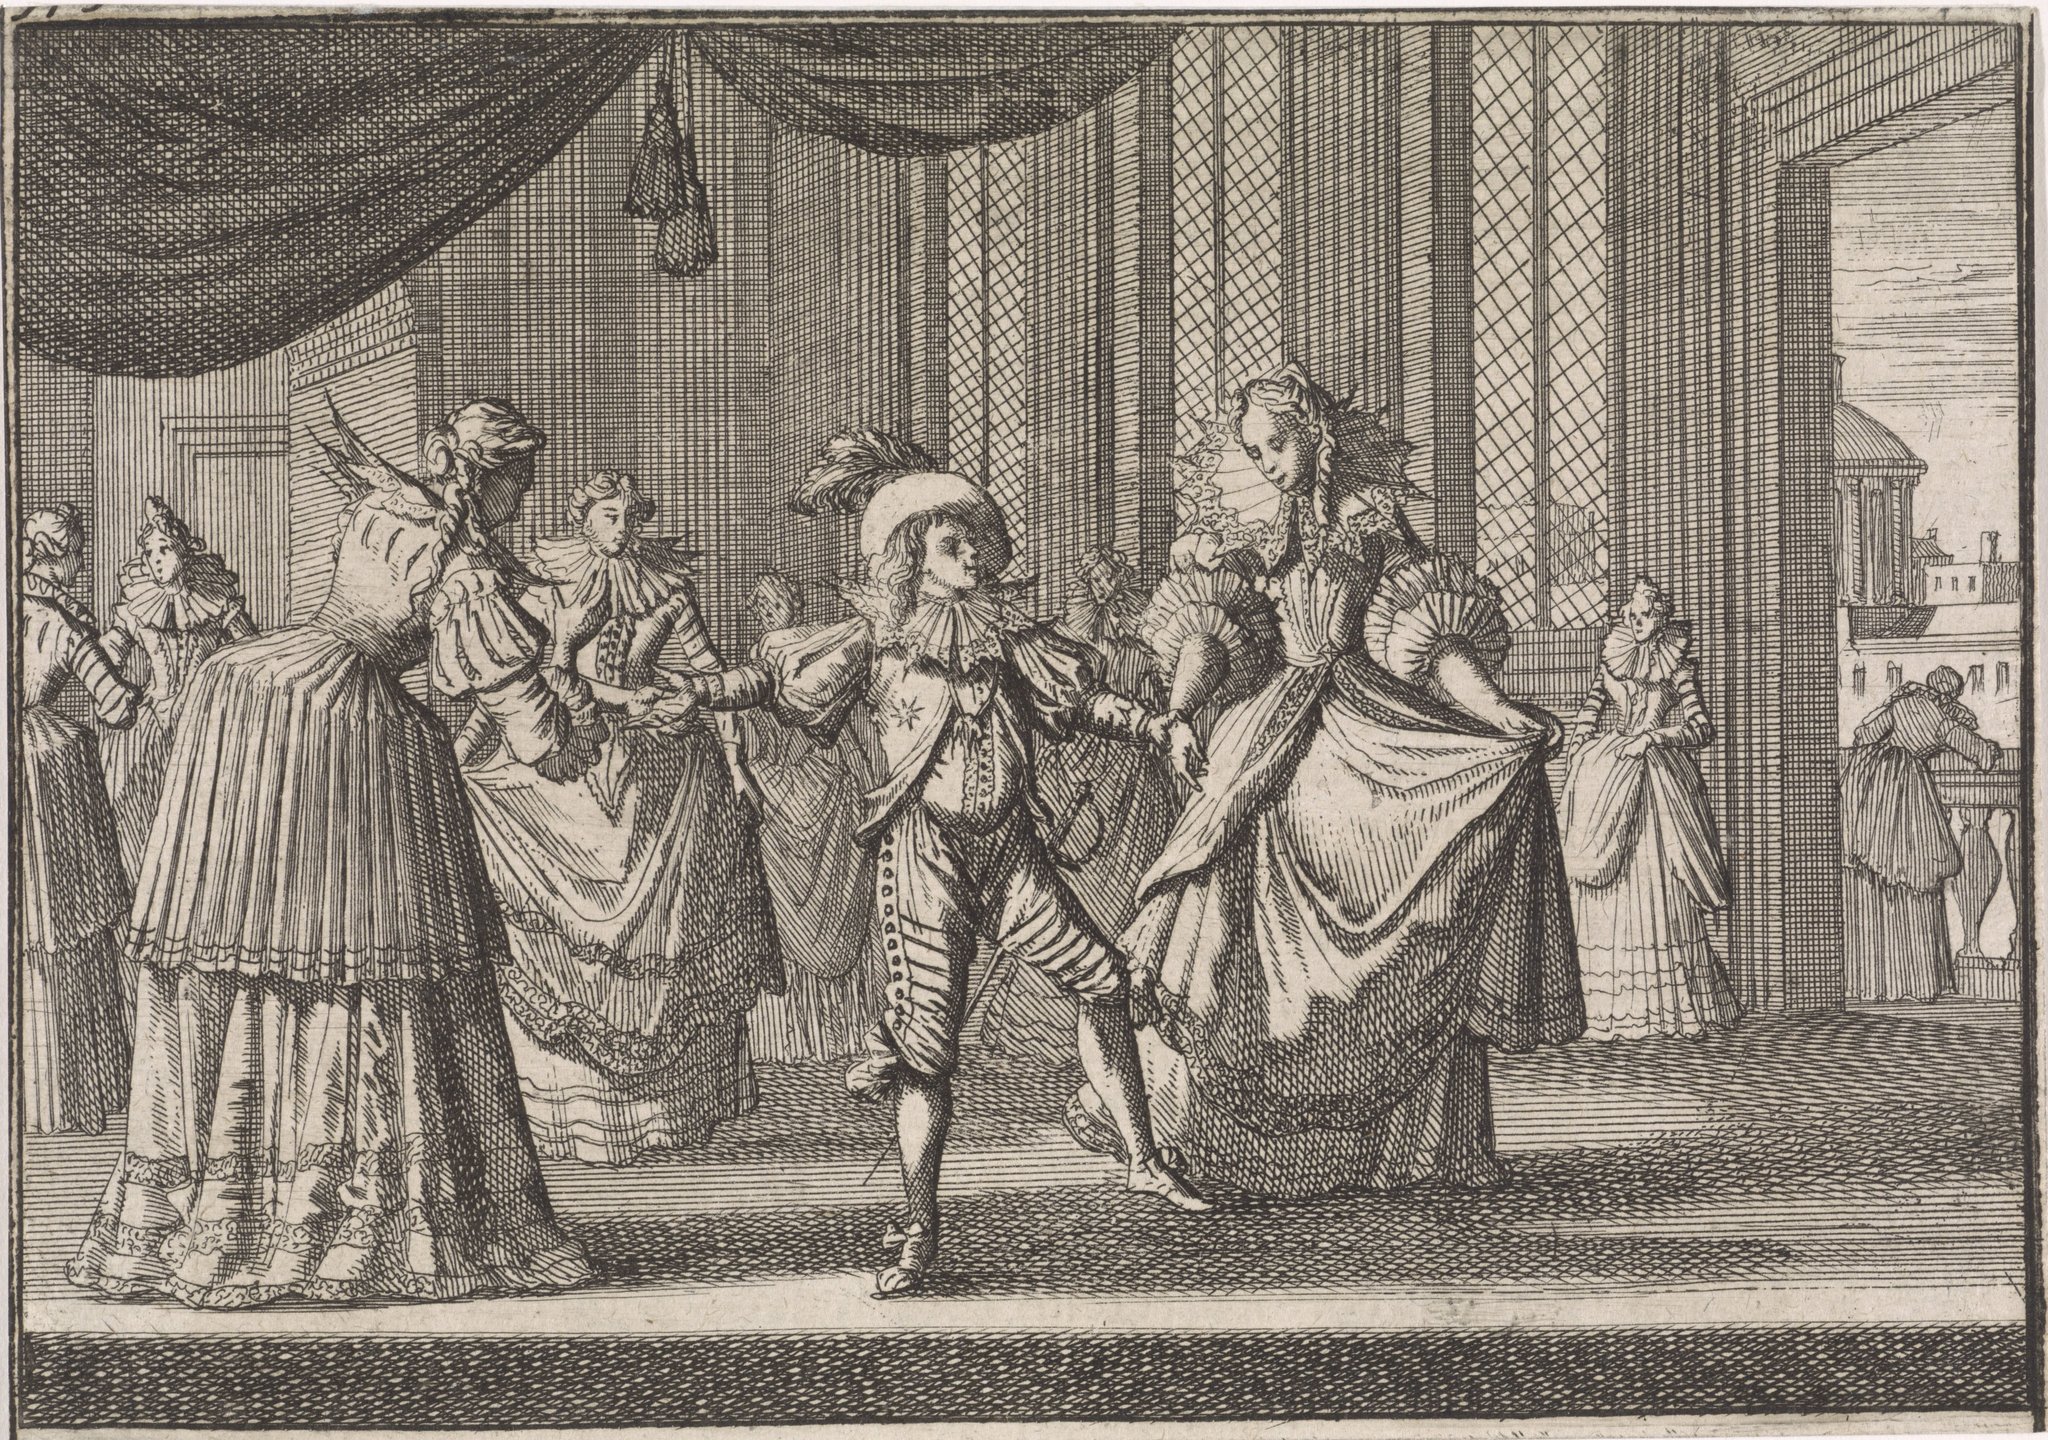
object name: print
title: Opvoeding van Balthazar Karel, de oudste zoon van koning Filips IV, 1642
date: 1701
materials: paper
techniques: etching, letterpress printing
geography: frankfurt am main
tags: group dancing among upper classes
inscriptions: collector's mark: Lugt 2228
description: Boekillustratie voor Hiob Ludolff. Allgemeine Schau-Bühne der Welt. Deel II. Frankfurt am Main: Johann David Zunnern, 1701, p. 973.